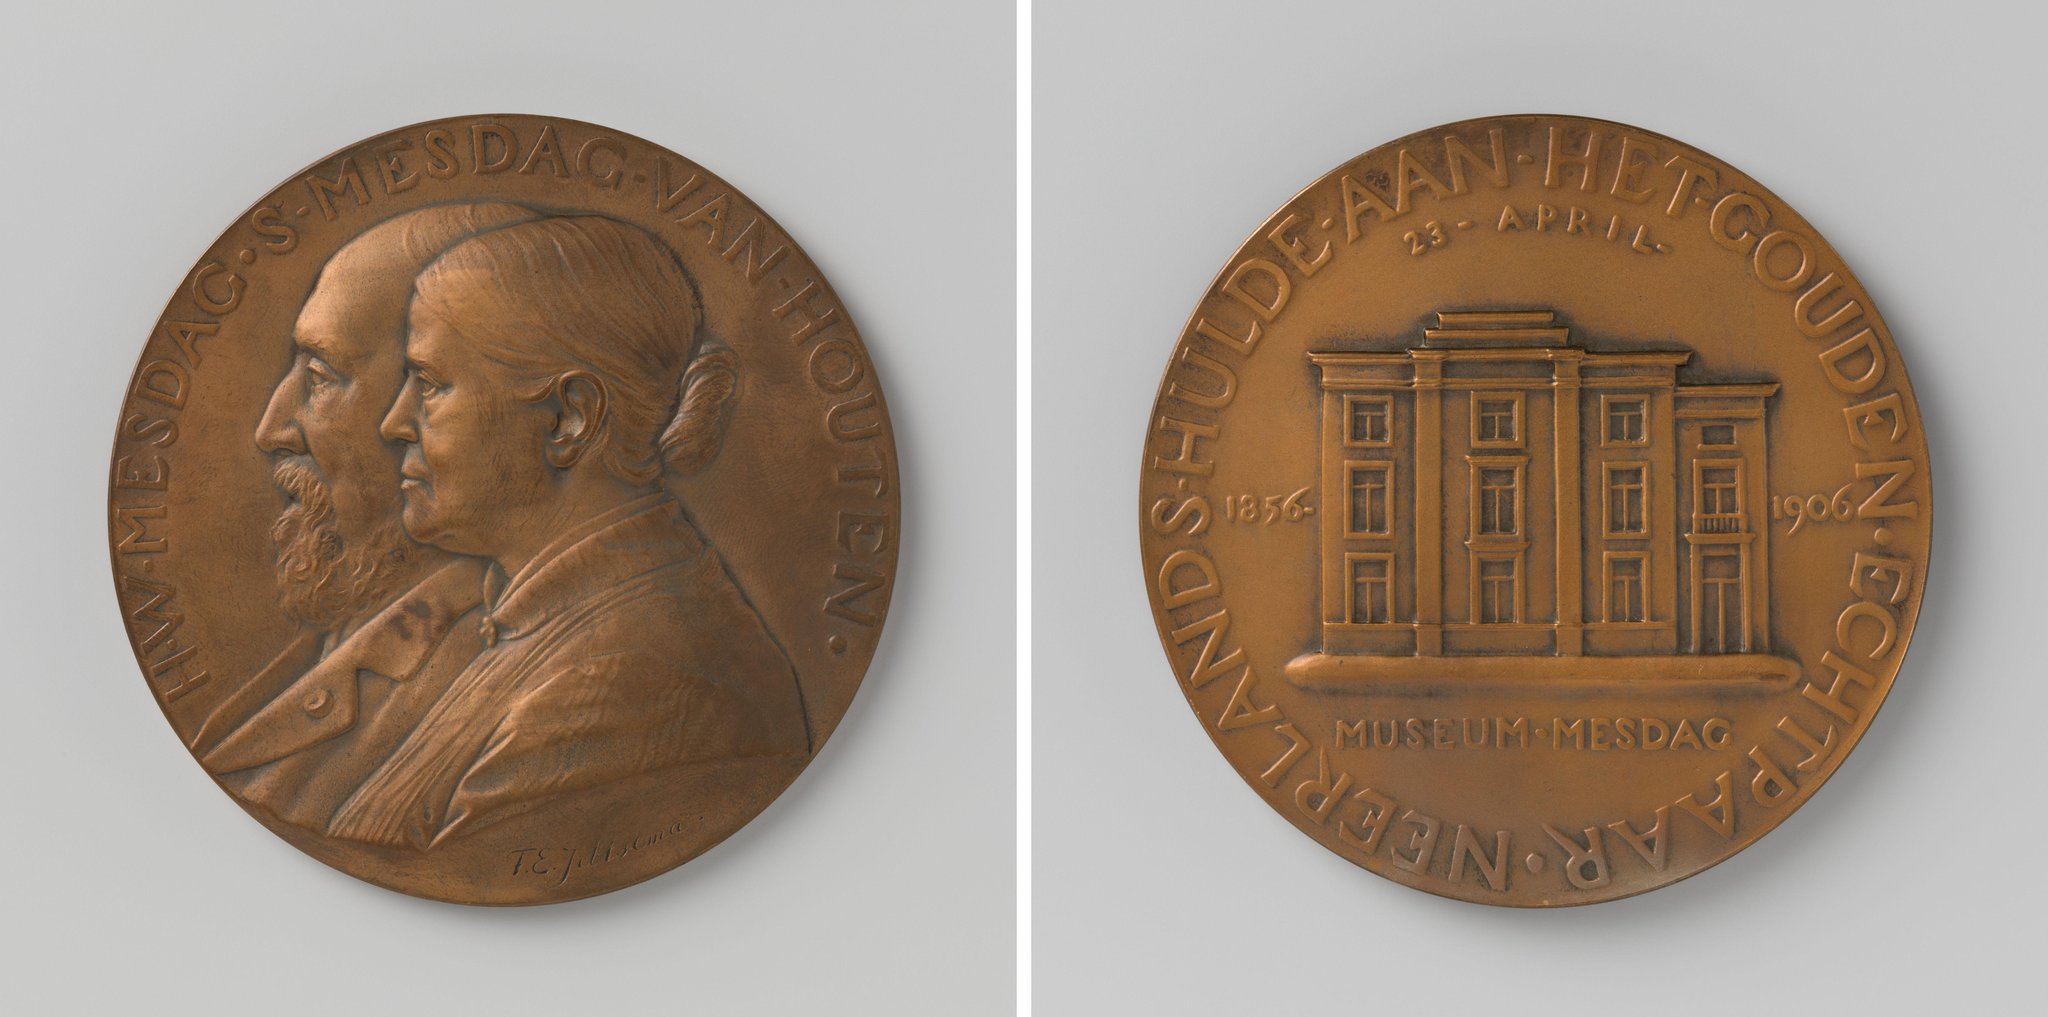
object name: honorary medal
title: Vijftigjarig huwelijk van Hendrik Willem Mesdag en Sientje Mesdag-van Houten, penning aangeboden door de Staat der Nederlanden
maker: carel begeer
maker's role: designer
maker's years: 1883-1956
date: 1906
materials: bronze, leather, silk, velvet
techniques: casting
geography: utrecht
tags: print maker, hendrik willem mesdag, the hague, painter, draughtsman, sientje mesdag-van houten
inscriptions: circumscription: ‘23 - APRIL -1856 - 1906 - MUSEUM. MESDAG / NEERLANDS. HULDE. AAN. HET. GOUDEN. ECHTPAAR’, circumscription: ‘H. W. MESDAG-S. MESDAG-VAN.HOUTEN’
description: Bronzen penning. Voorzijde: borststukken man en vrouw in profiel naar links (accol é) binnen omschrift. Keerzijde: gezicht op museum Mesdag te Den Haag tussen jaartallen, boven opschrift en binnen omschrift. Met bijbehorende doos NG-165-2.